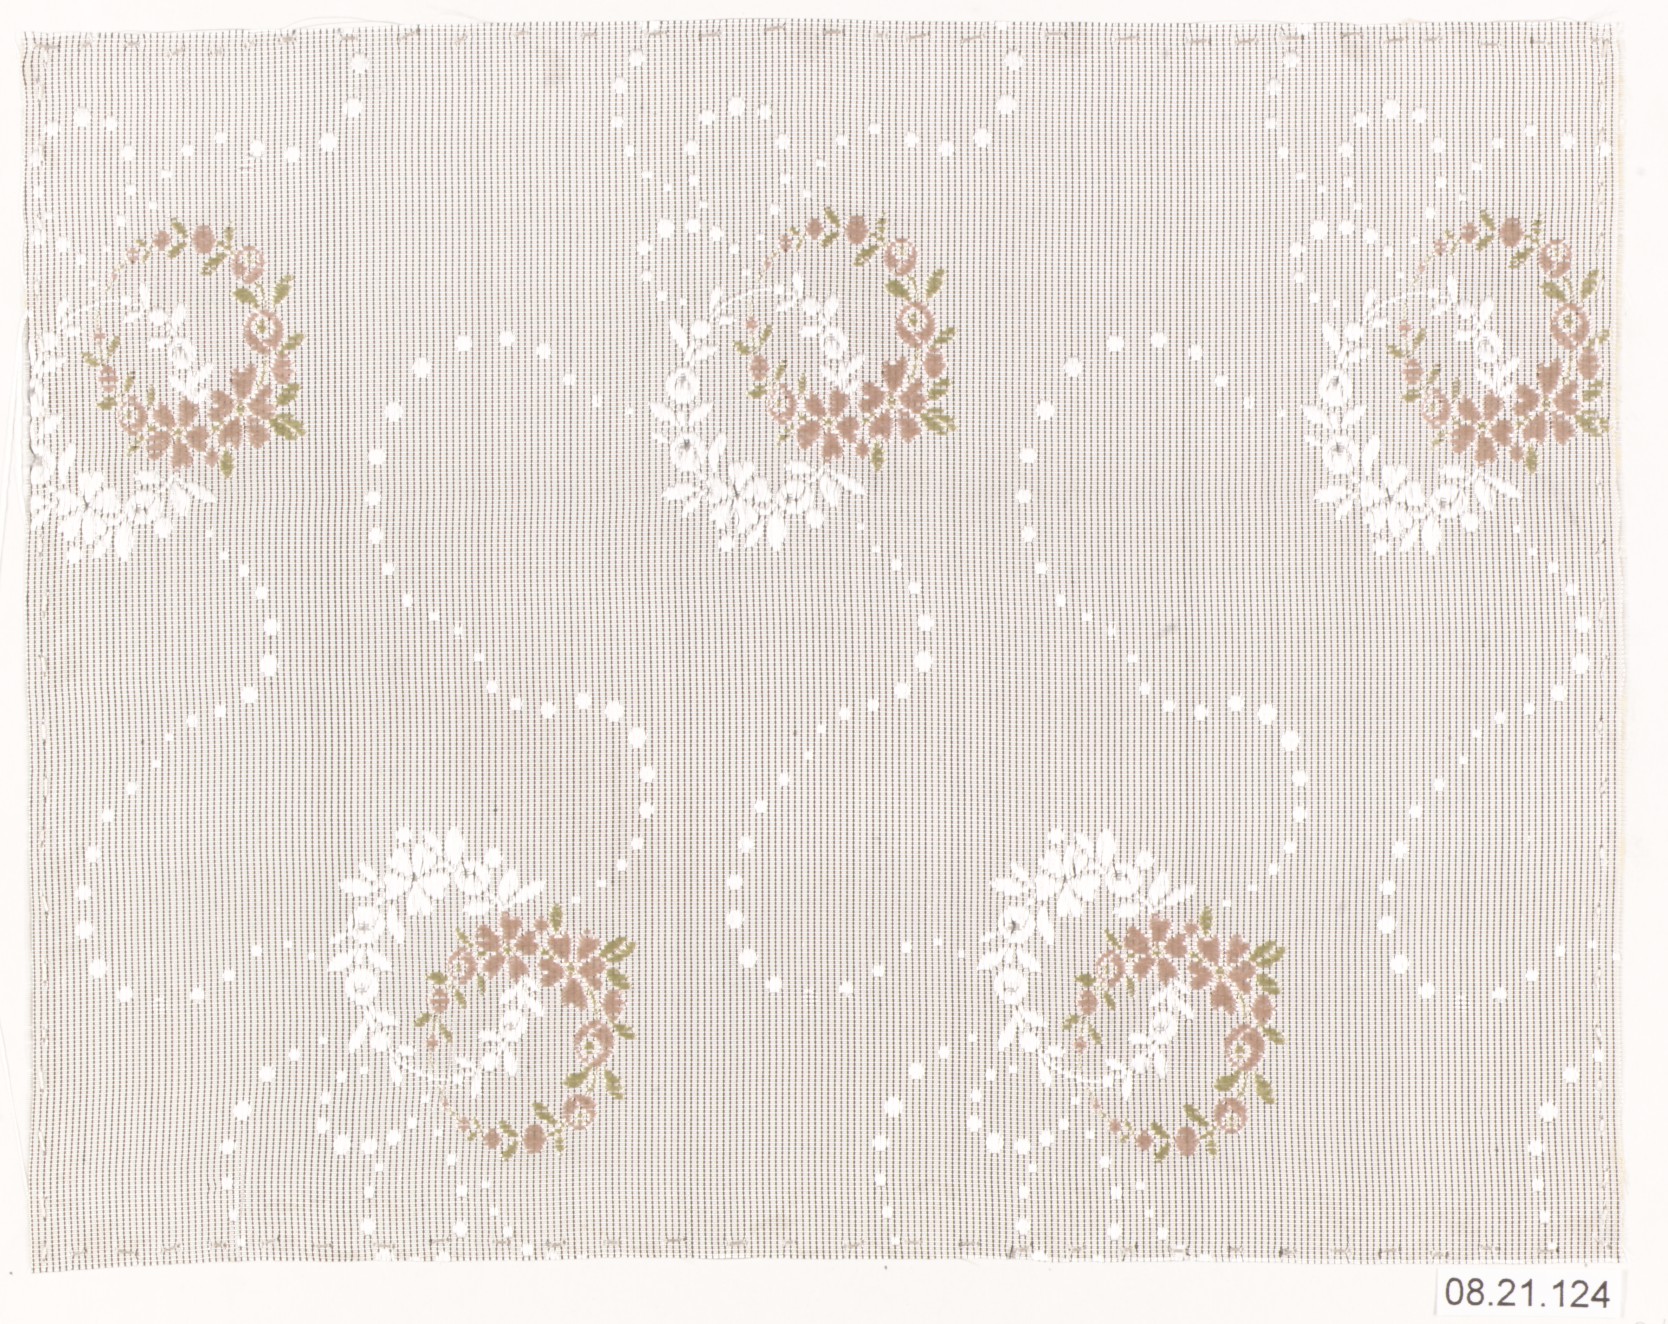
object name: textile sample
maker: Anonymous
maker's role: designer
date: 1900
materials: silk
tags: flowers